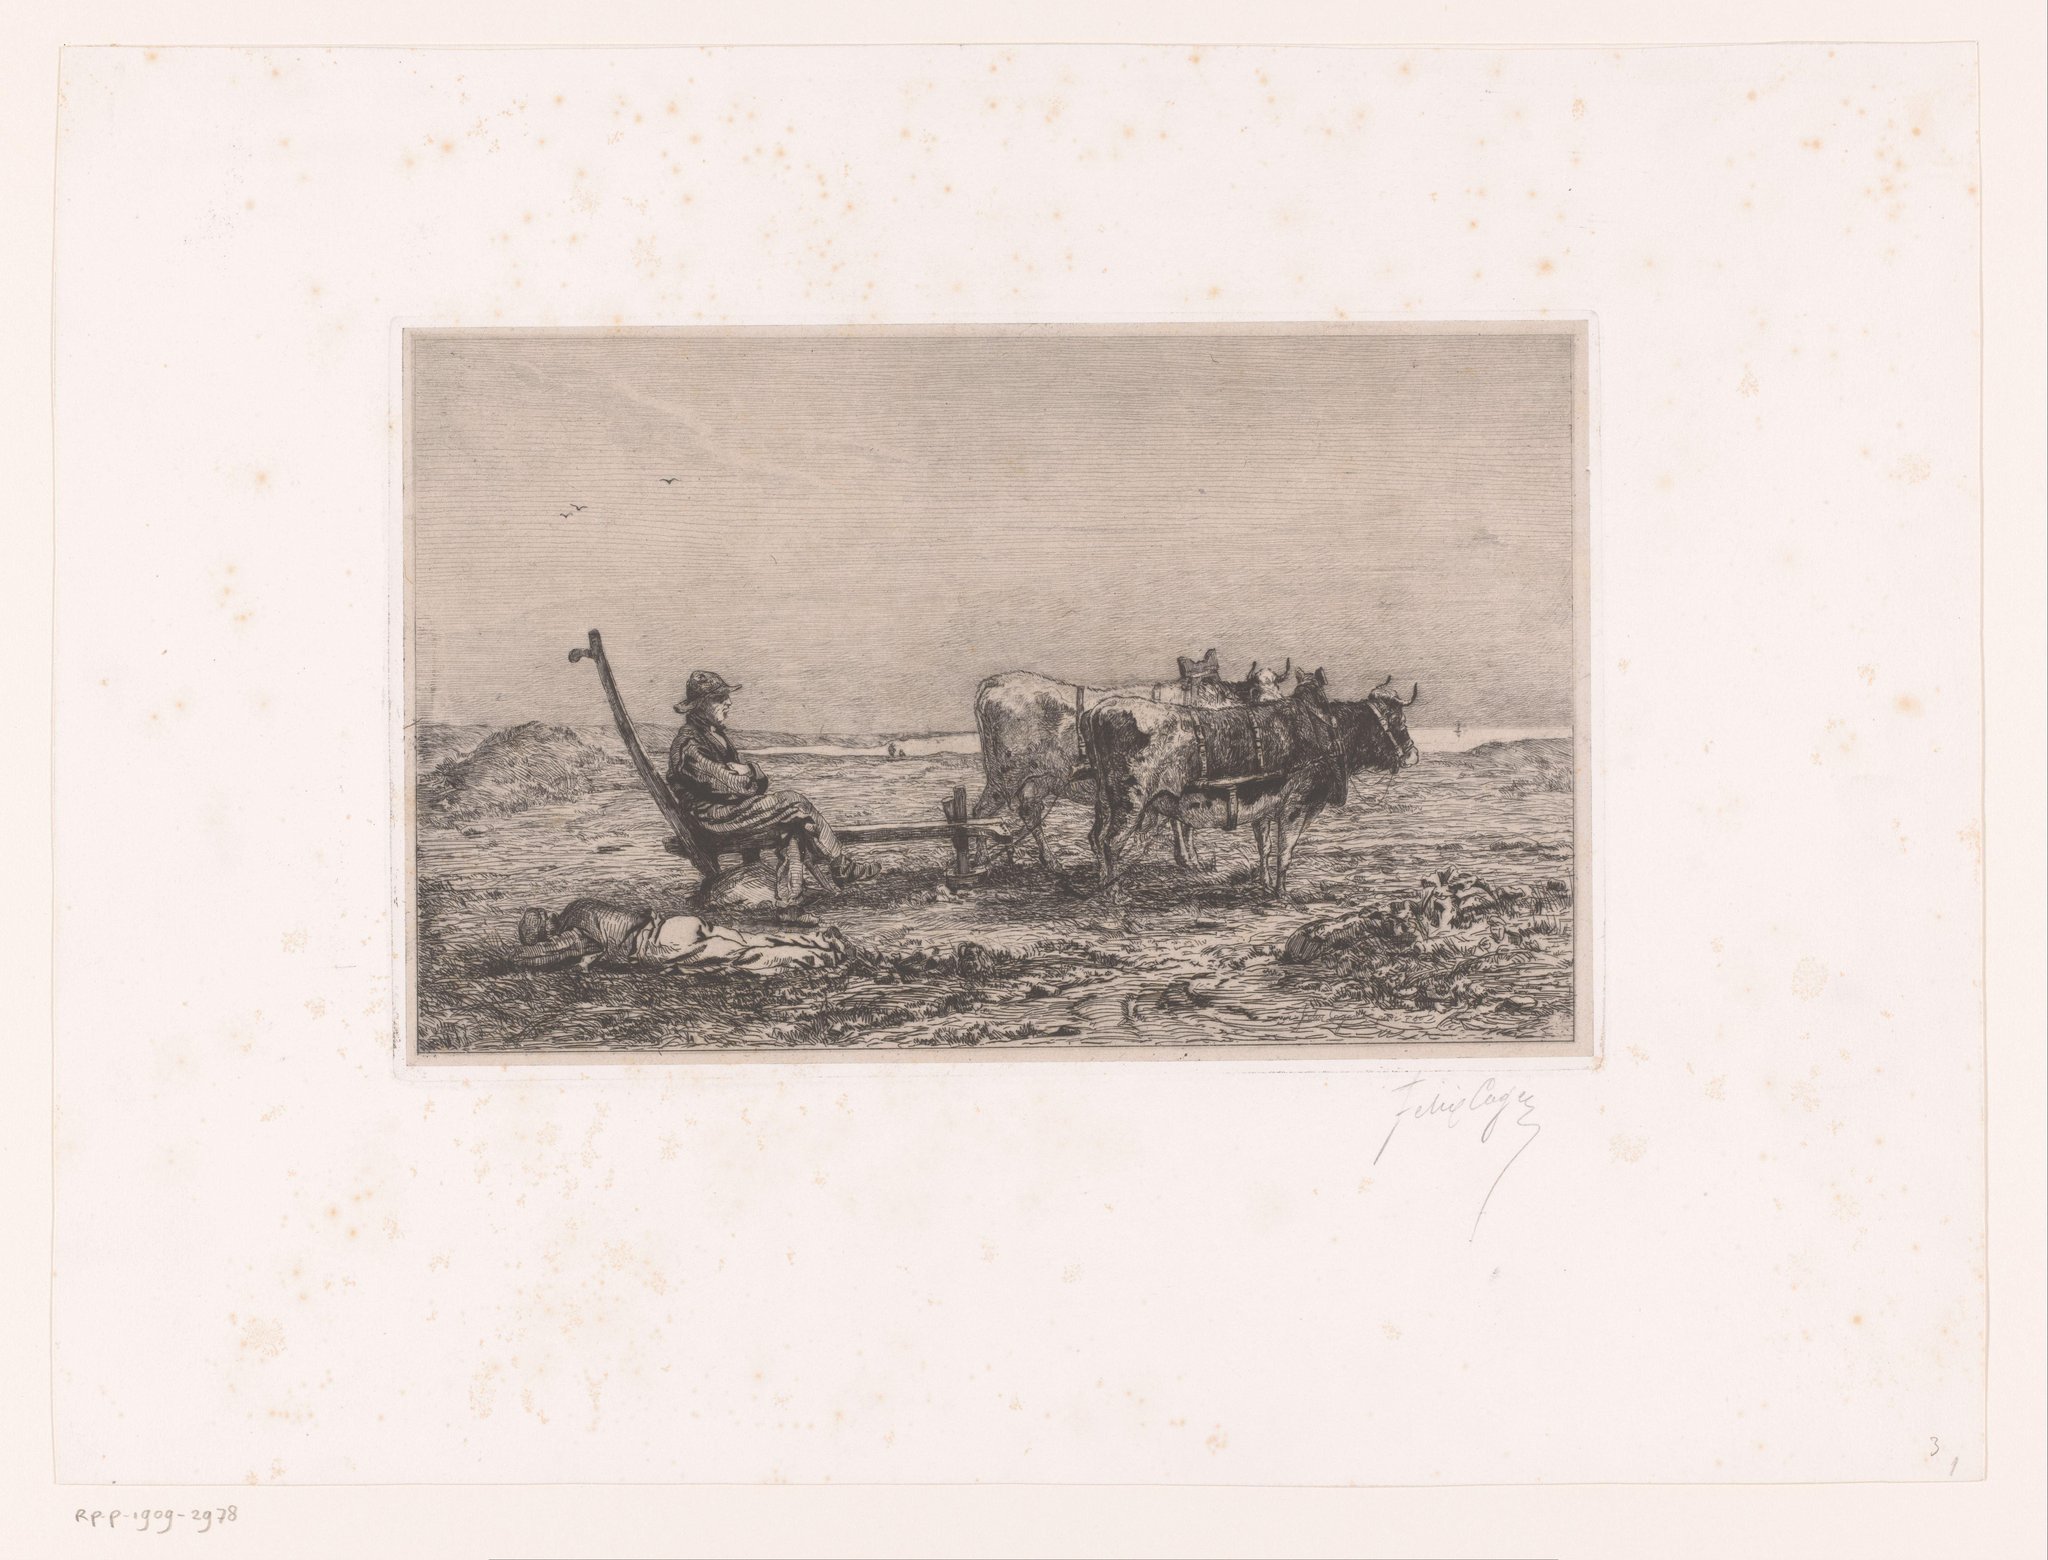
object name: print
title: Boeren op het land met een ploeg en twee runderen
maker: félix cogen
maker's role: print maker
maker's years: 1838-1907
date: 1848-1907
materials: paper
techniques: drypoint, etching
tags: farmers, agricultural implements: plough, bovine cattle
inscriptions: collector's mark: Lugt 2228